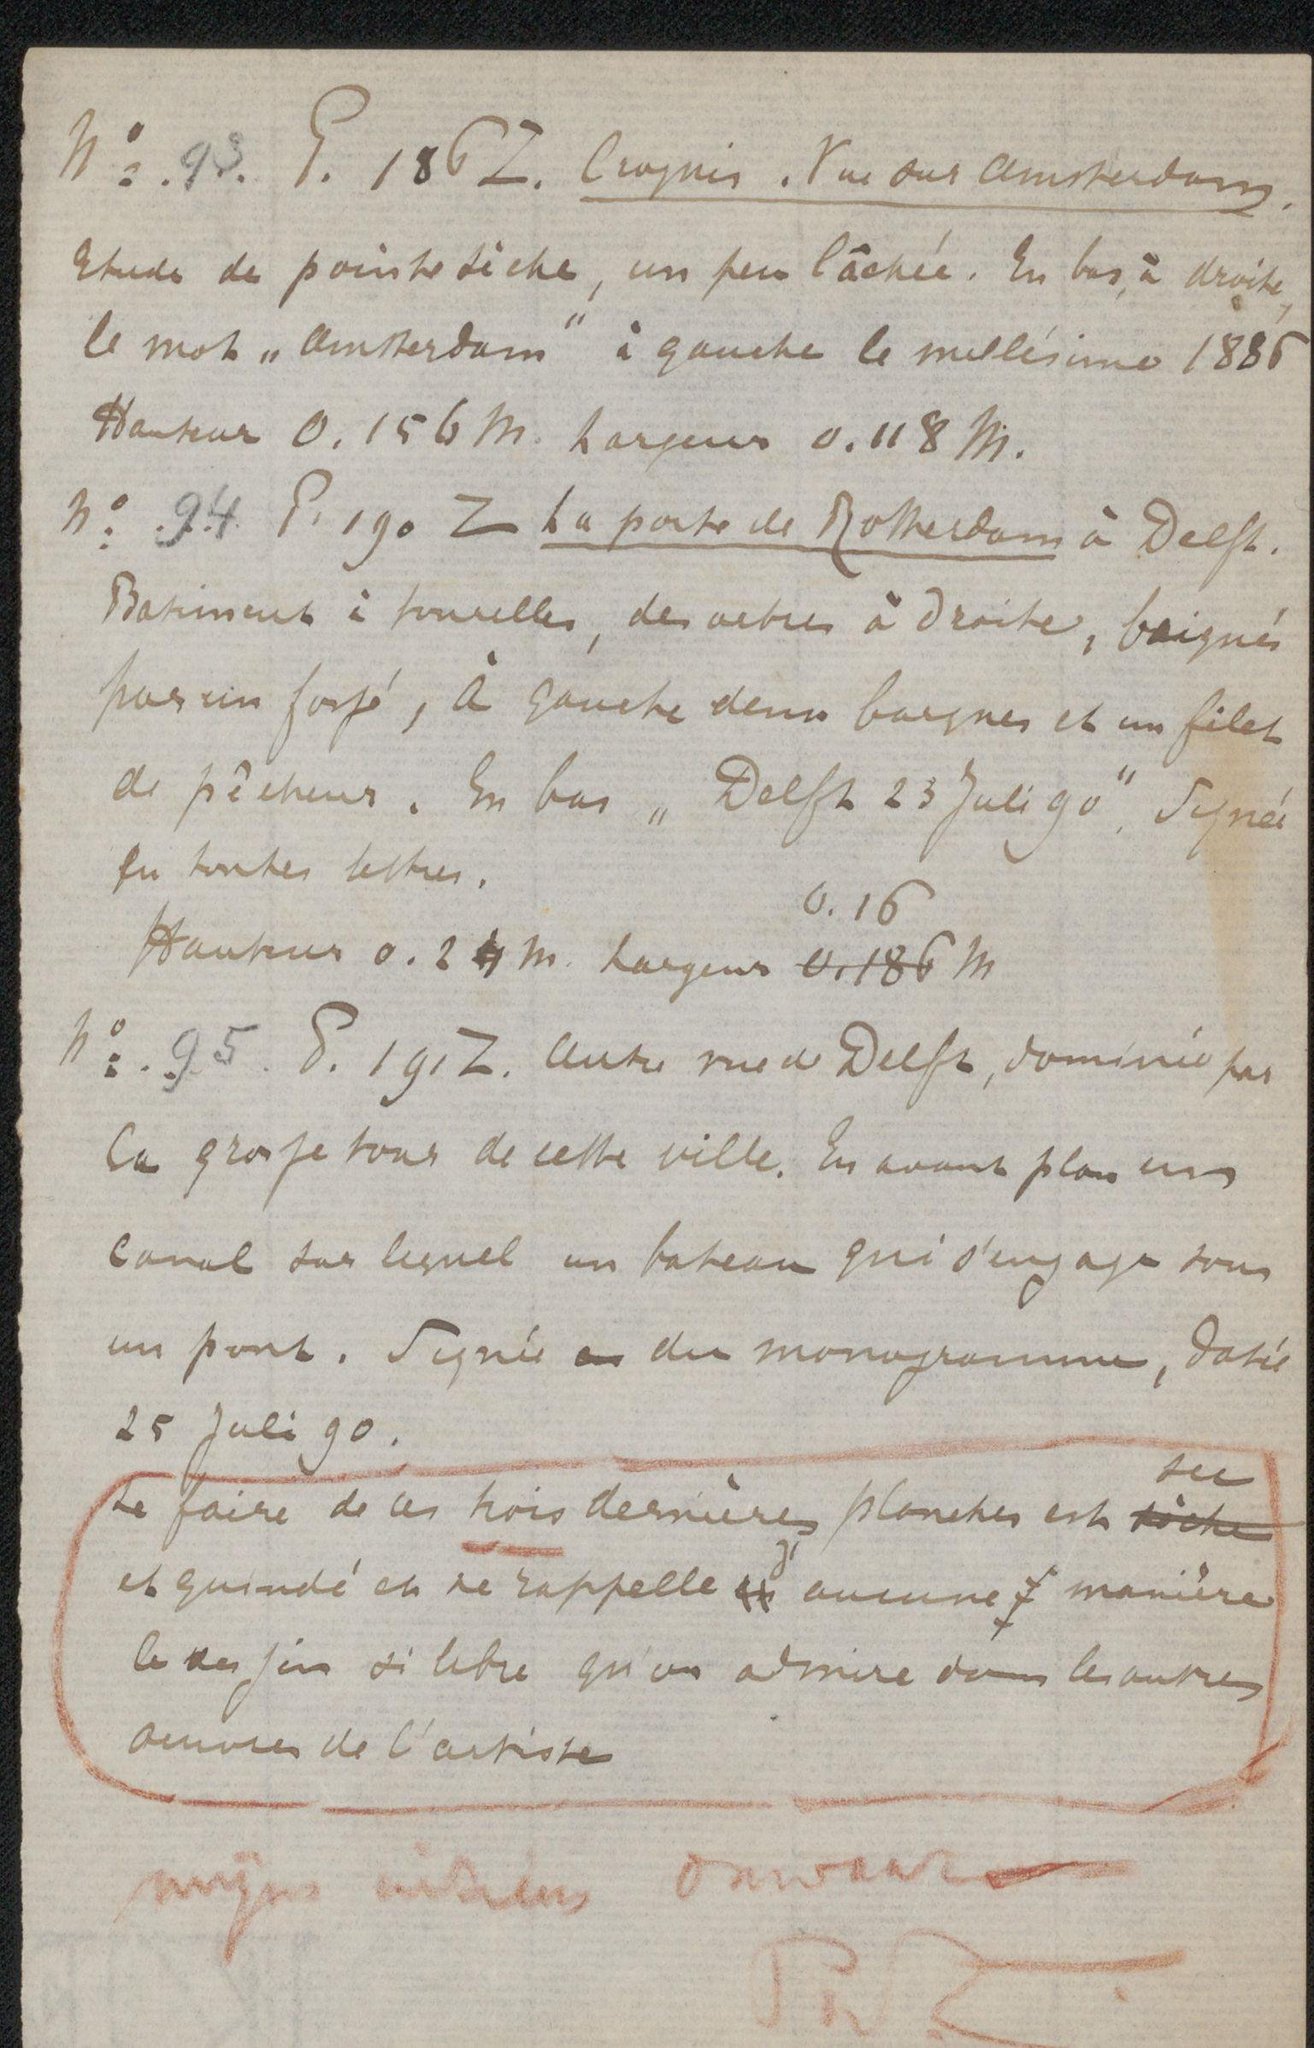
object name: aantekening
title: Aantekening uit archief Philip Zilcken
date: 1867-1930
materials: ink, paper, pencil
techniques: pen, writing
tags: the hague, nijmegen, print maker, adriaan pit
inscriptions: collector's mark: ‘RPK’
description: Aantekening werd bewaard bij correspondentie van Adriaan Pit aan Philip Zilcken.